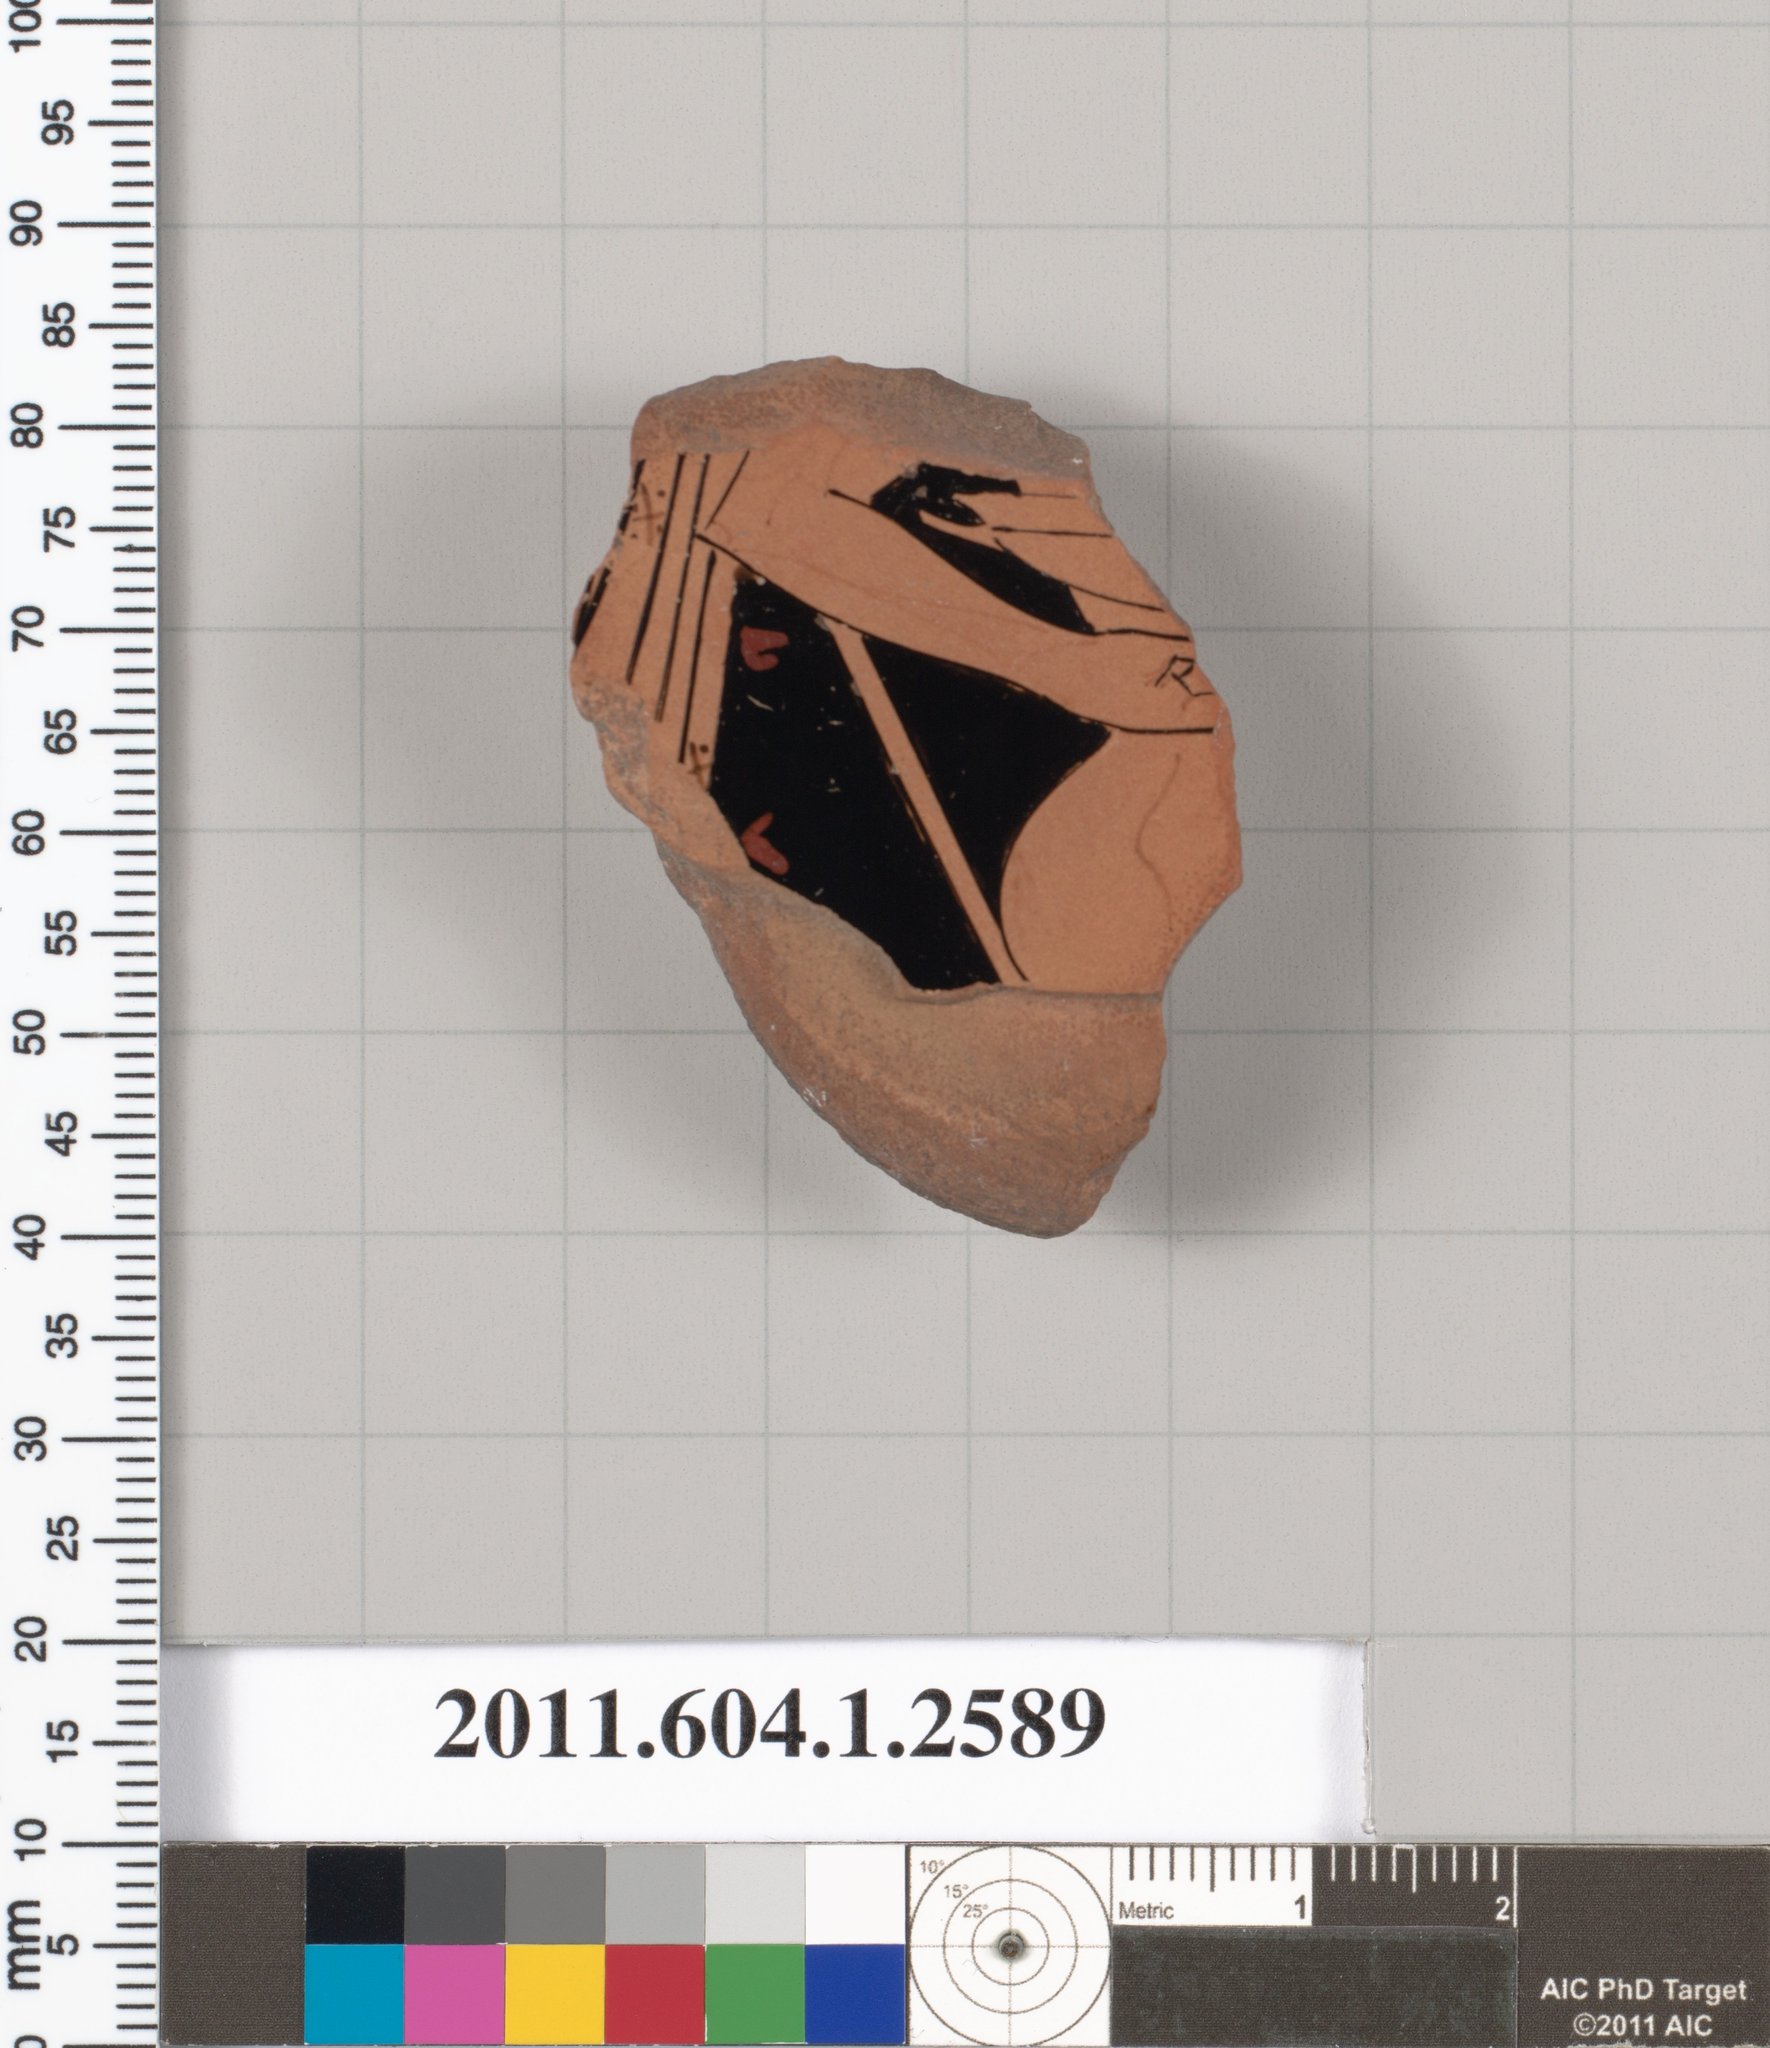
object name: kylix fragment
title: Terracotta fragment of a kylix (drinking cup)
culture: greek, attic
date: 490-480 BCE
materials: terracotta